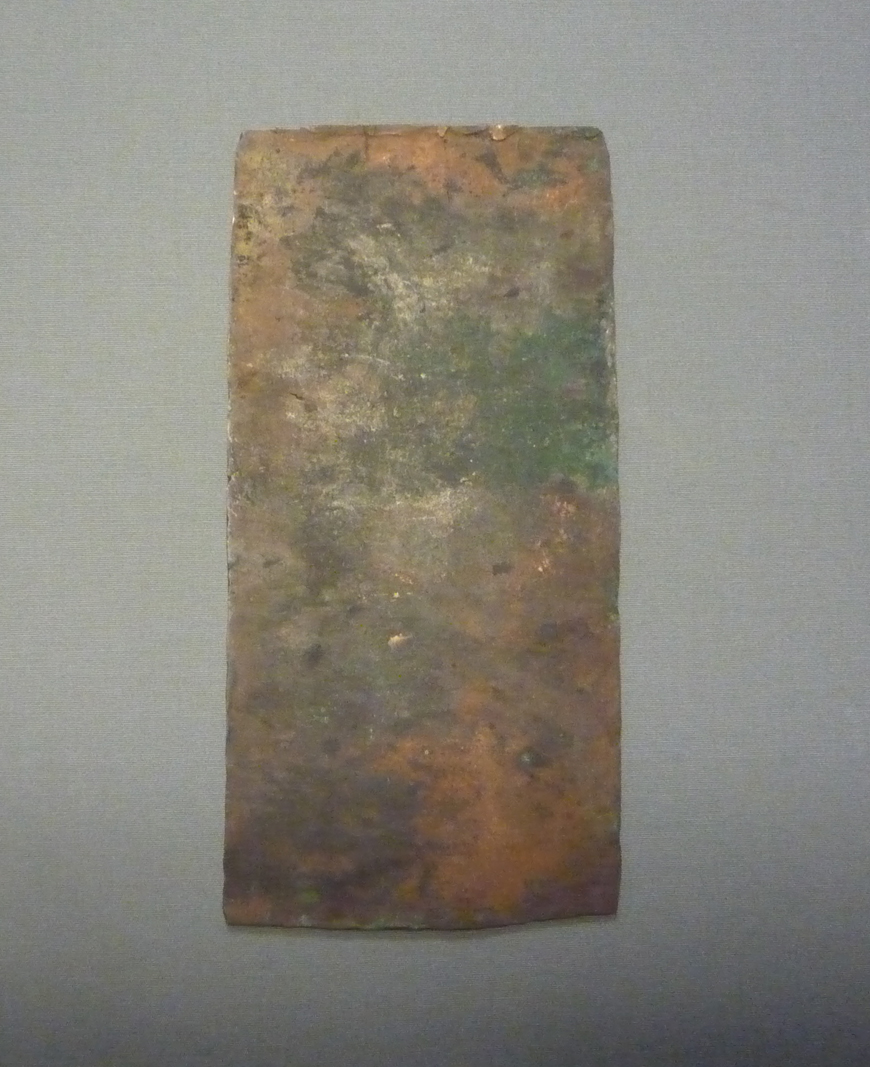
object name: plaque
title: Copper Plaque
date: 1479-1458 BCE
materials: copper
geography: egypt